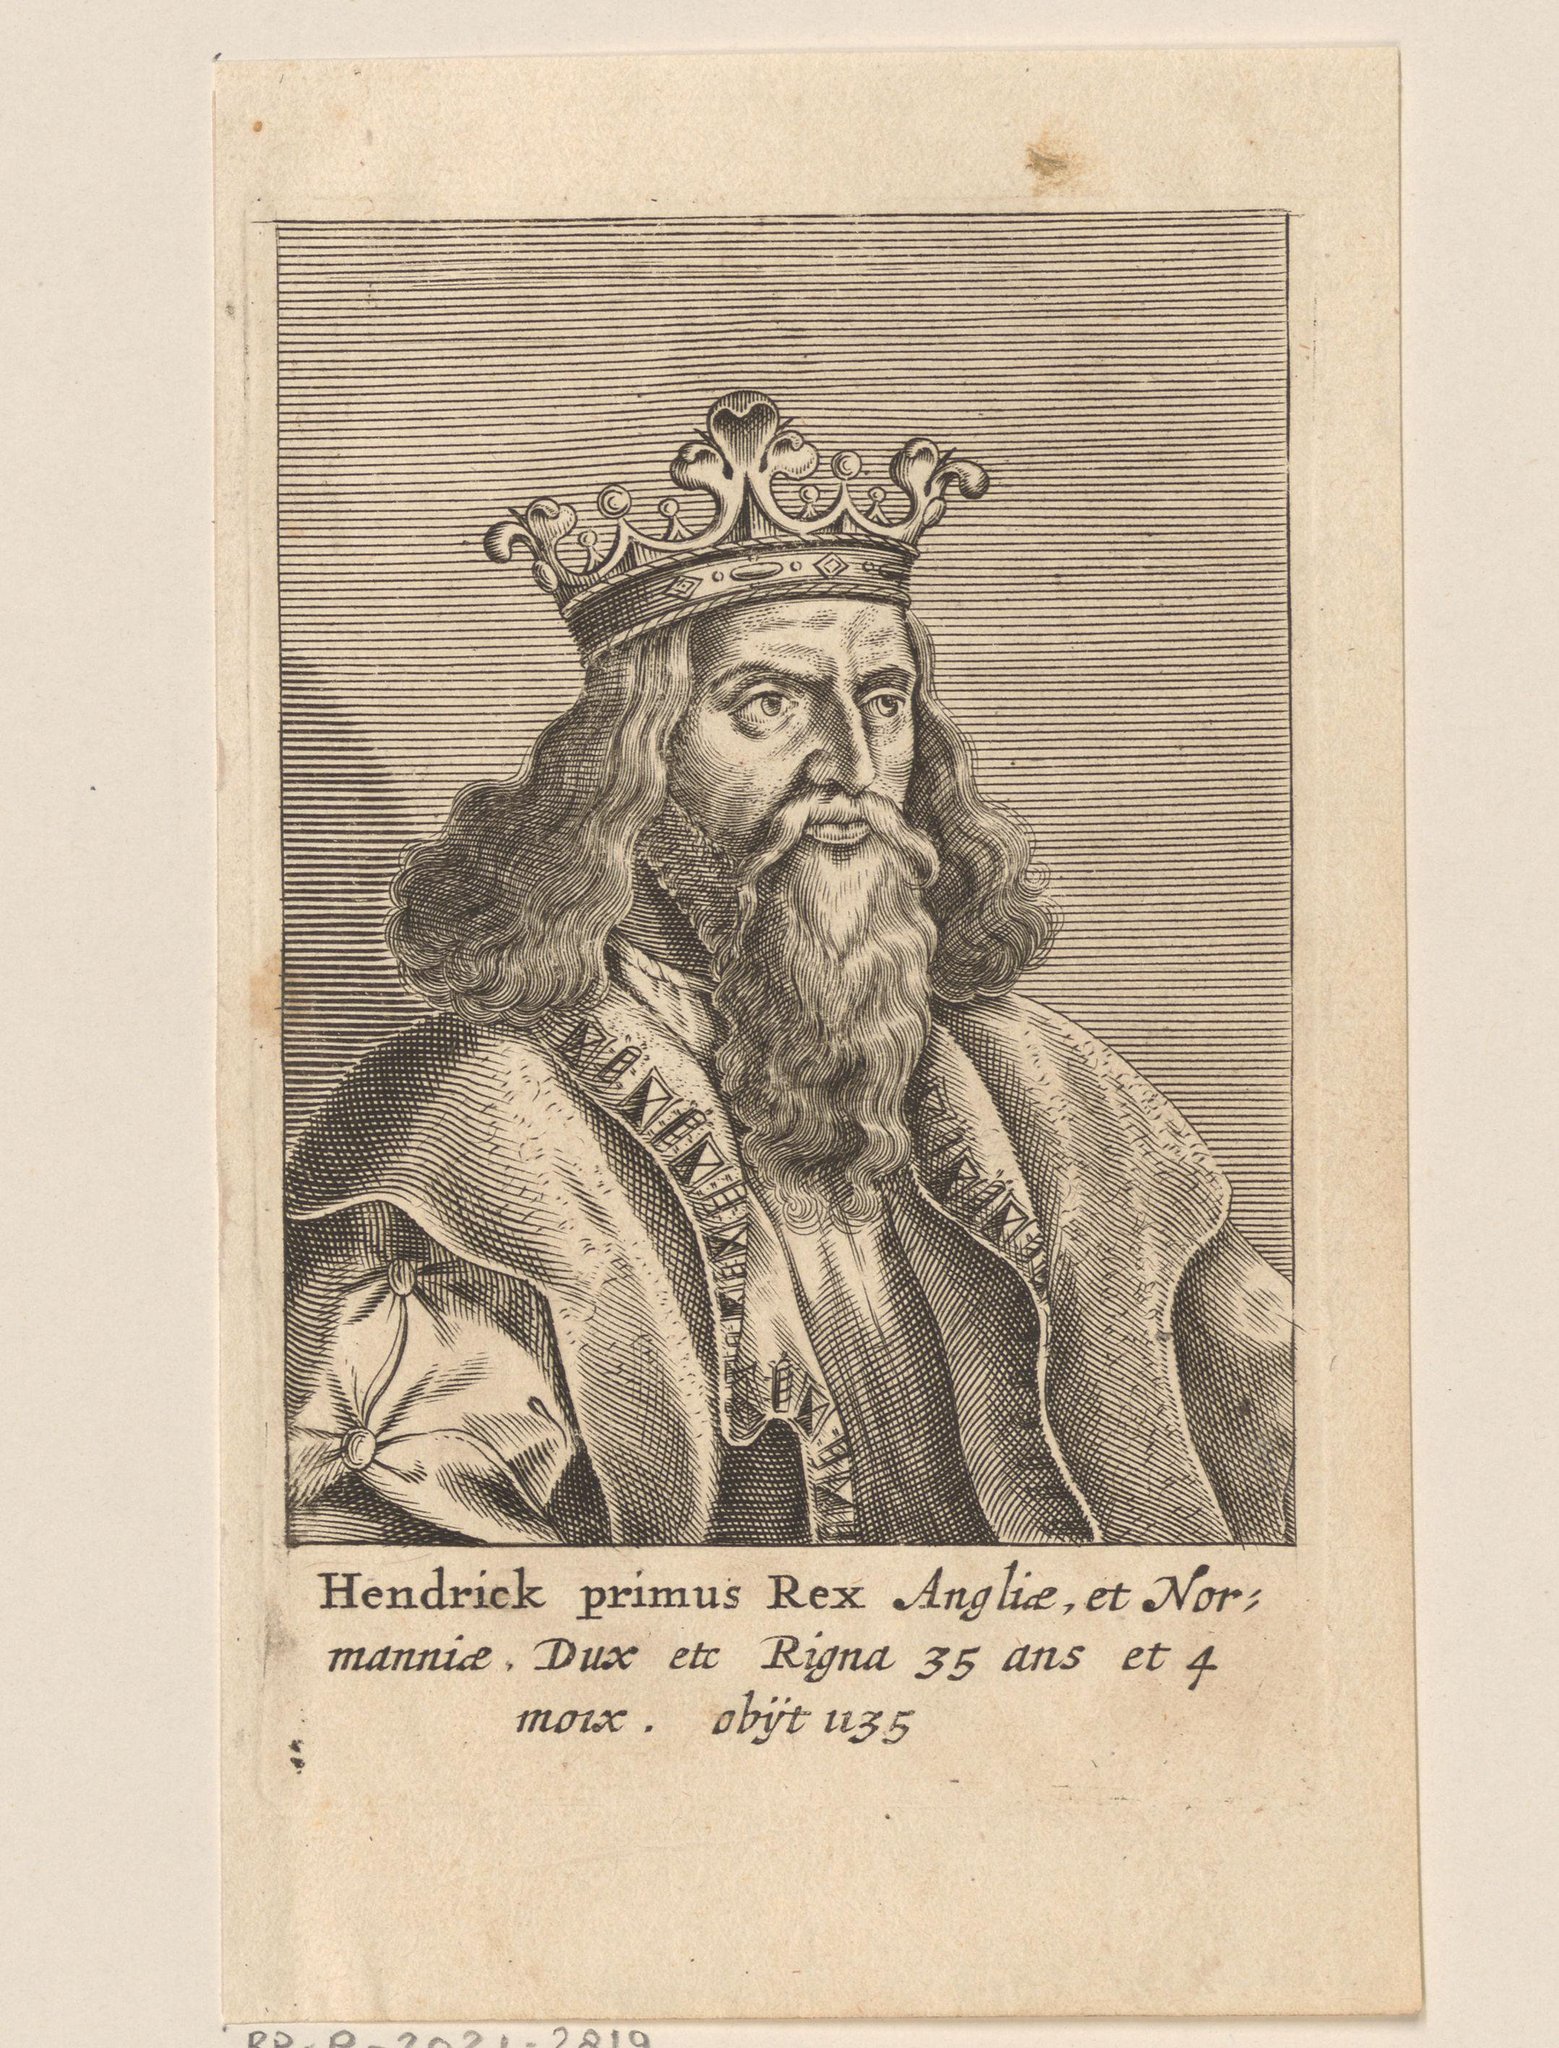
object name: print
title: Portret van Hendrik I, koning van Engeland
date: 1681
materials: paper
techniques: engraving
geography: amsterdam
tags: historical persons, king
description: Prent uit: Baker, Richard. Chronyck van het leven en bedrijf van al de koningen van Engelandt. Amsterdam: weduwe Jan Jacobsz. Schipper, 1681. Prent eerder gebruikt, met tekst op verso, in de eerste editie uitgegeven door Cornelis Dankertsz. in 1649.